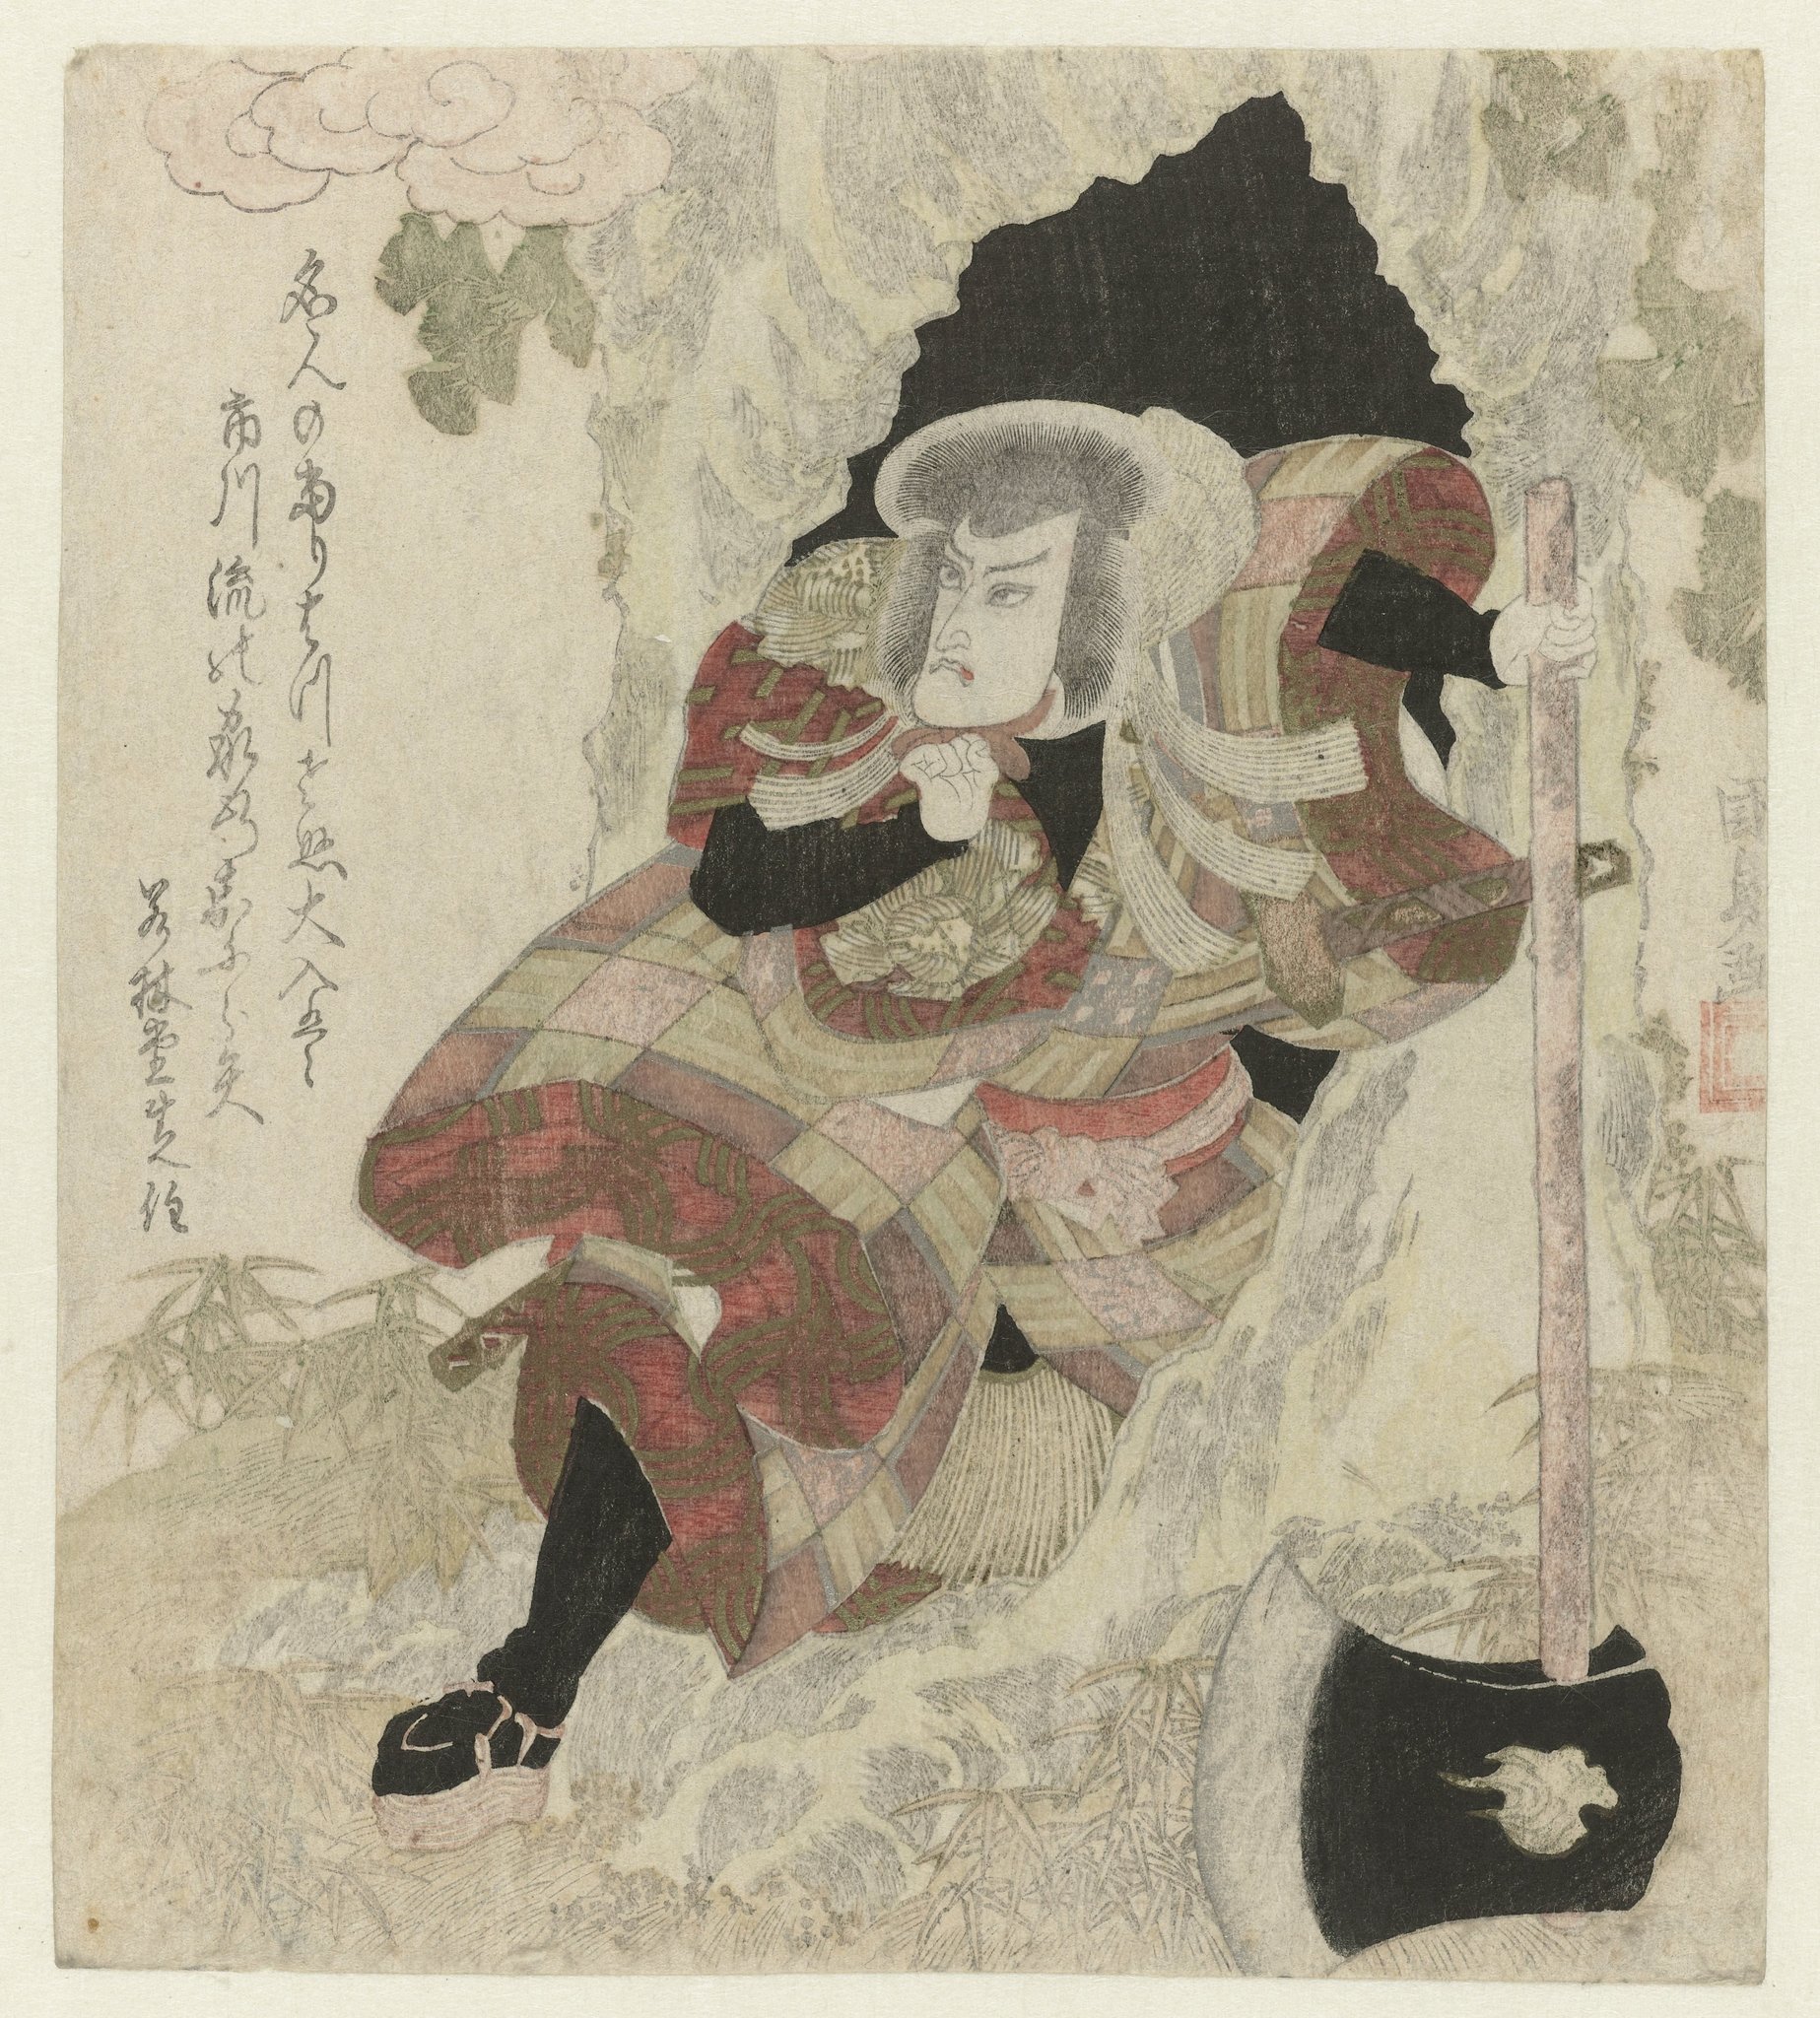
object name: print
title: Man met bijl stapt uit een boom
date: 1820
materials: paper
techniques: woodcut, polish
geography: japan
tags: trees, adult man, tools, aids, implements ~ crafts and industries: axe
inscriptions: collector's mark, verso, stamped: Lugt 2228, collector's mark, passe-partout, bottom left, printed: JABdH with a rooster.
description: Een surimono is een luxe uitgevoerde prent waarop beeld met één of meerdere gedichten gecombineerd is. Bij het drukken van een surimono werd vaak gebruik gemaakt van dikker papier, blinddruk en metaal pigmenten, zoals koper- en zilverpoeder. De prenten werden vaak in opdracht van dichters gemaakt en als exclusief geschenk aan vrienden en relaties gegeven.